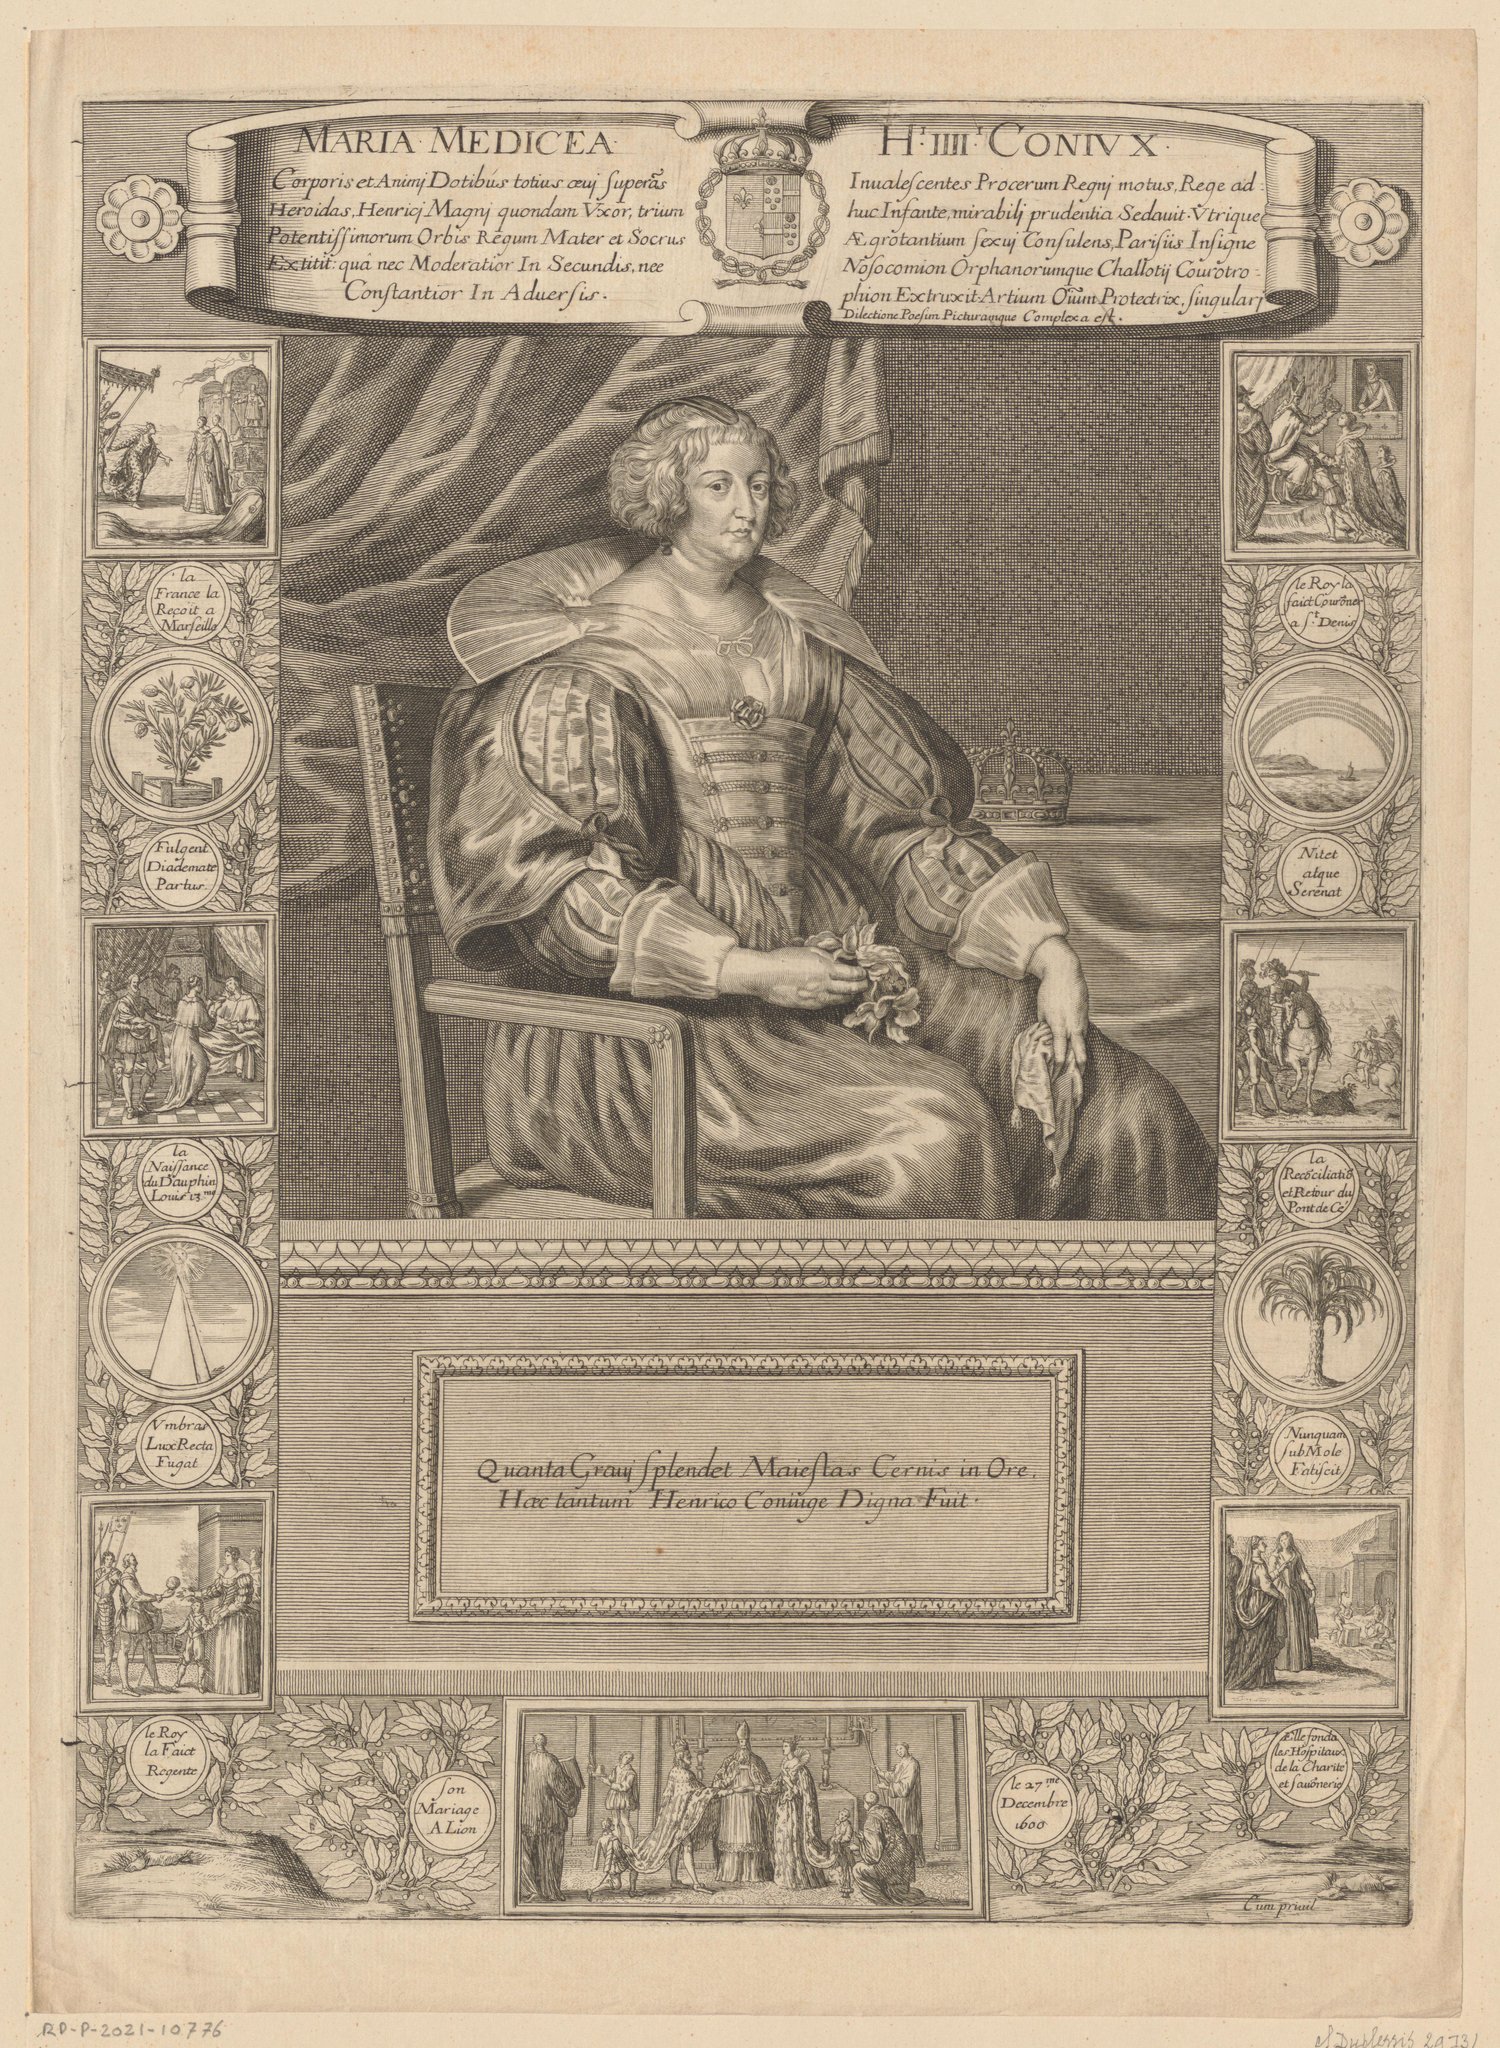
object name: print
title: Portretten uit het paleis van kardinaal de Richelieu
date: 1650-1690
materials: paper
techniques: engraving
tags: cologne, print maker, maria de' medici, procreation, birth and (early) youth, crown (symbol of sovereignty), historical persons - bb - woman, trees: olive-tree, trees: palm-tree, sitting on an elevation, armorial bearing, heraldry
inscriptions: collector's mark: Lugt 2228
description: Prent mogelijk uit: Vulson de La Colombière, Marc de. Les portraits des hommes illustres François qui sont peints dans la gallerie du Palais cardinal de Richelieu (...). Parijs: Henry Sara et al., 1650. Of uit latere publicaties (1655, 1662, 1690 en 1690).